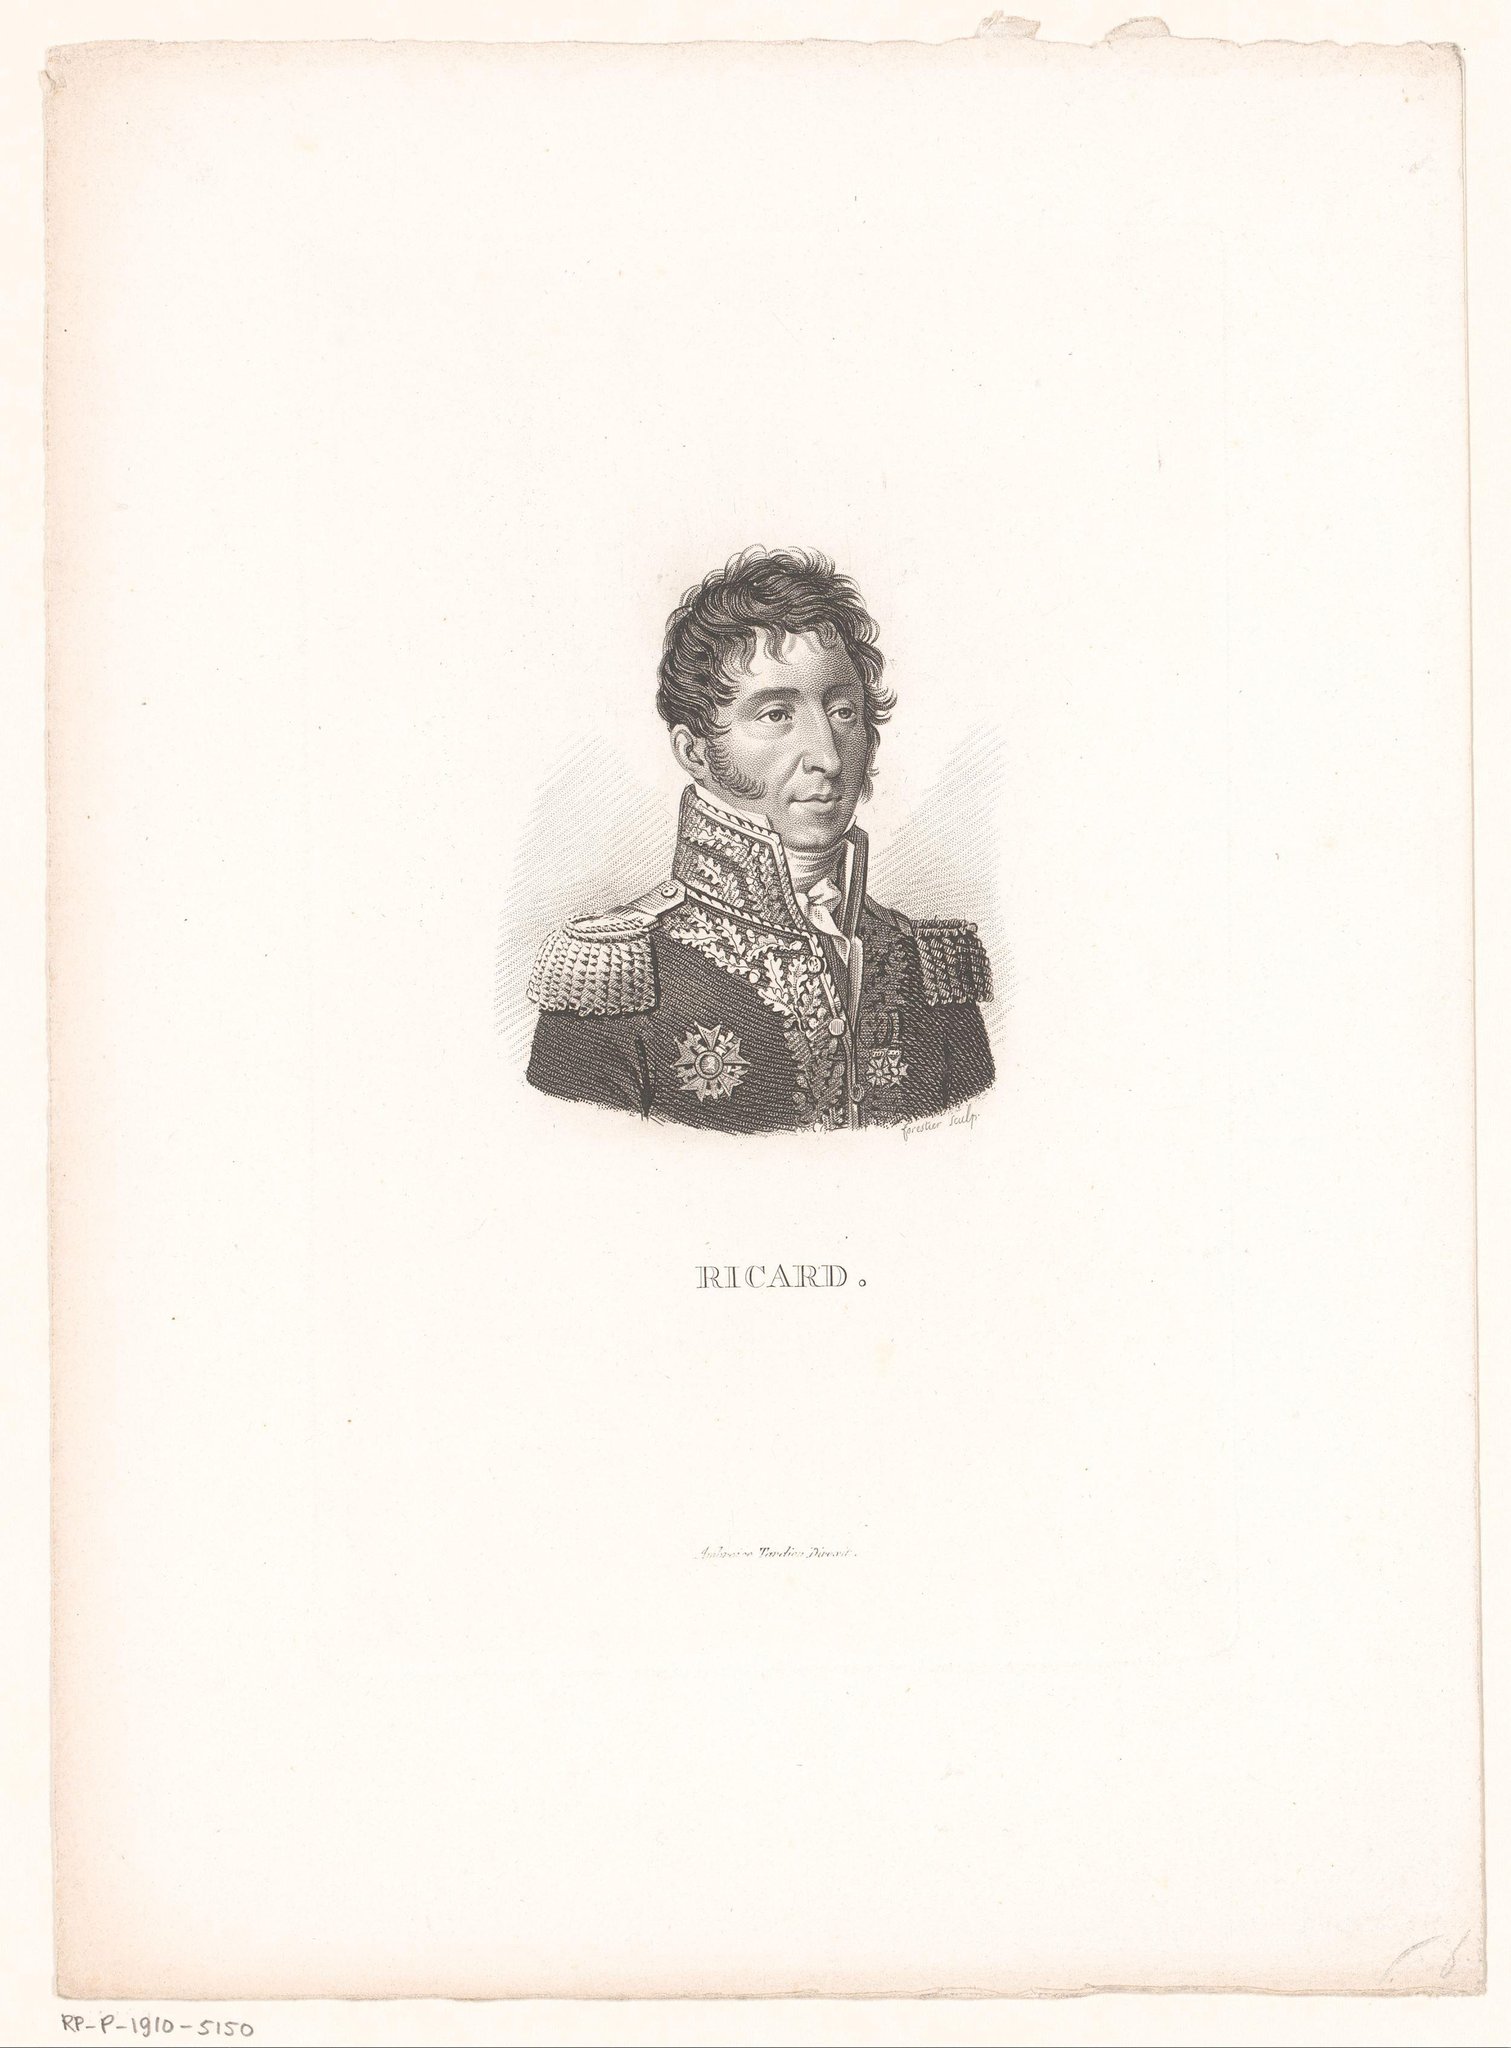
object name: book illustration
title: Portret van Étienne Pierre Sylvestre Ricard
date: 1818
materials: paper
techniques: engraving, etching, roulette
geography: paris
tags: politician, commander-in-chief, general, marshal, historical persons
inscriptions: collector's mark: Lugt 2228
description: Mogelijk prent uit: Tardieu, Ambroise. Portraits des généraux français, faisant suite aux "Victoires et conquêtes des Français". Parijs: Panckoucke, Charles Louis Fleury, ca. 1818.